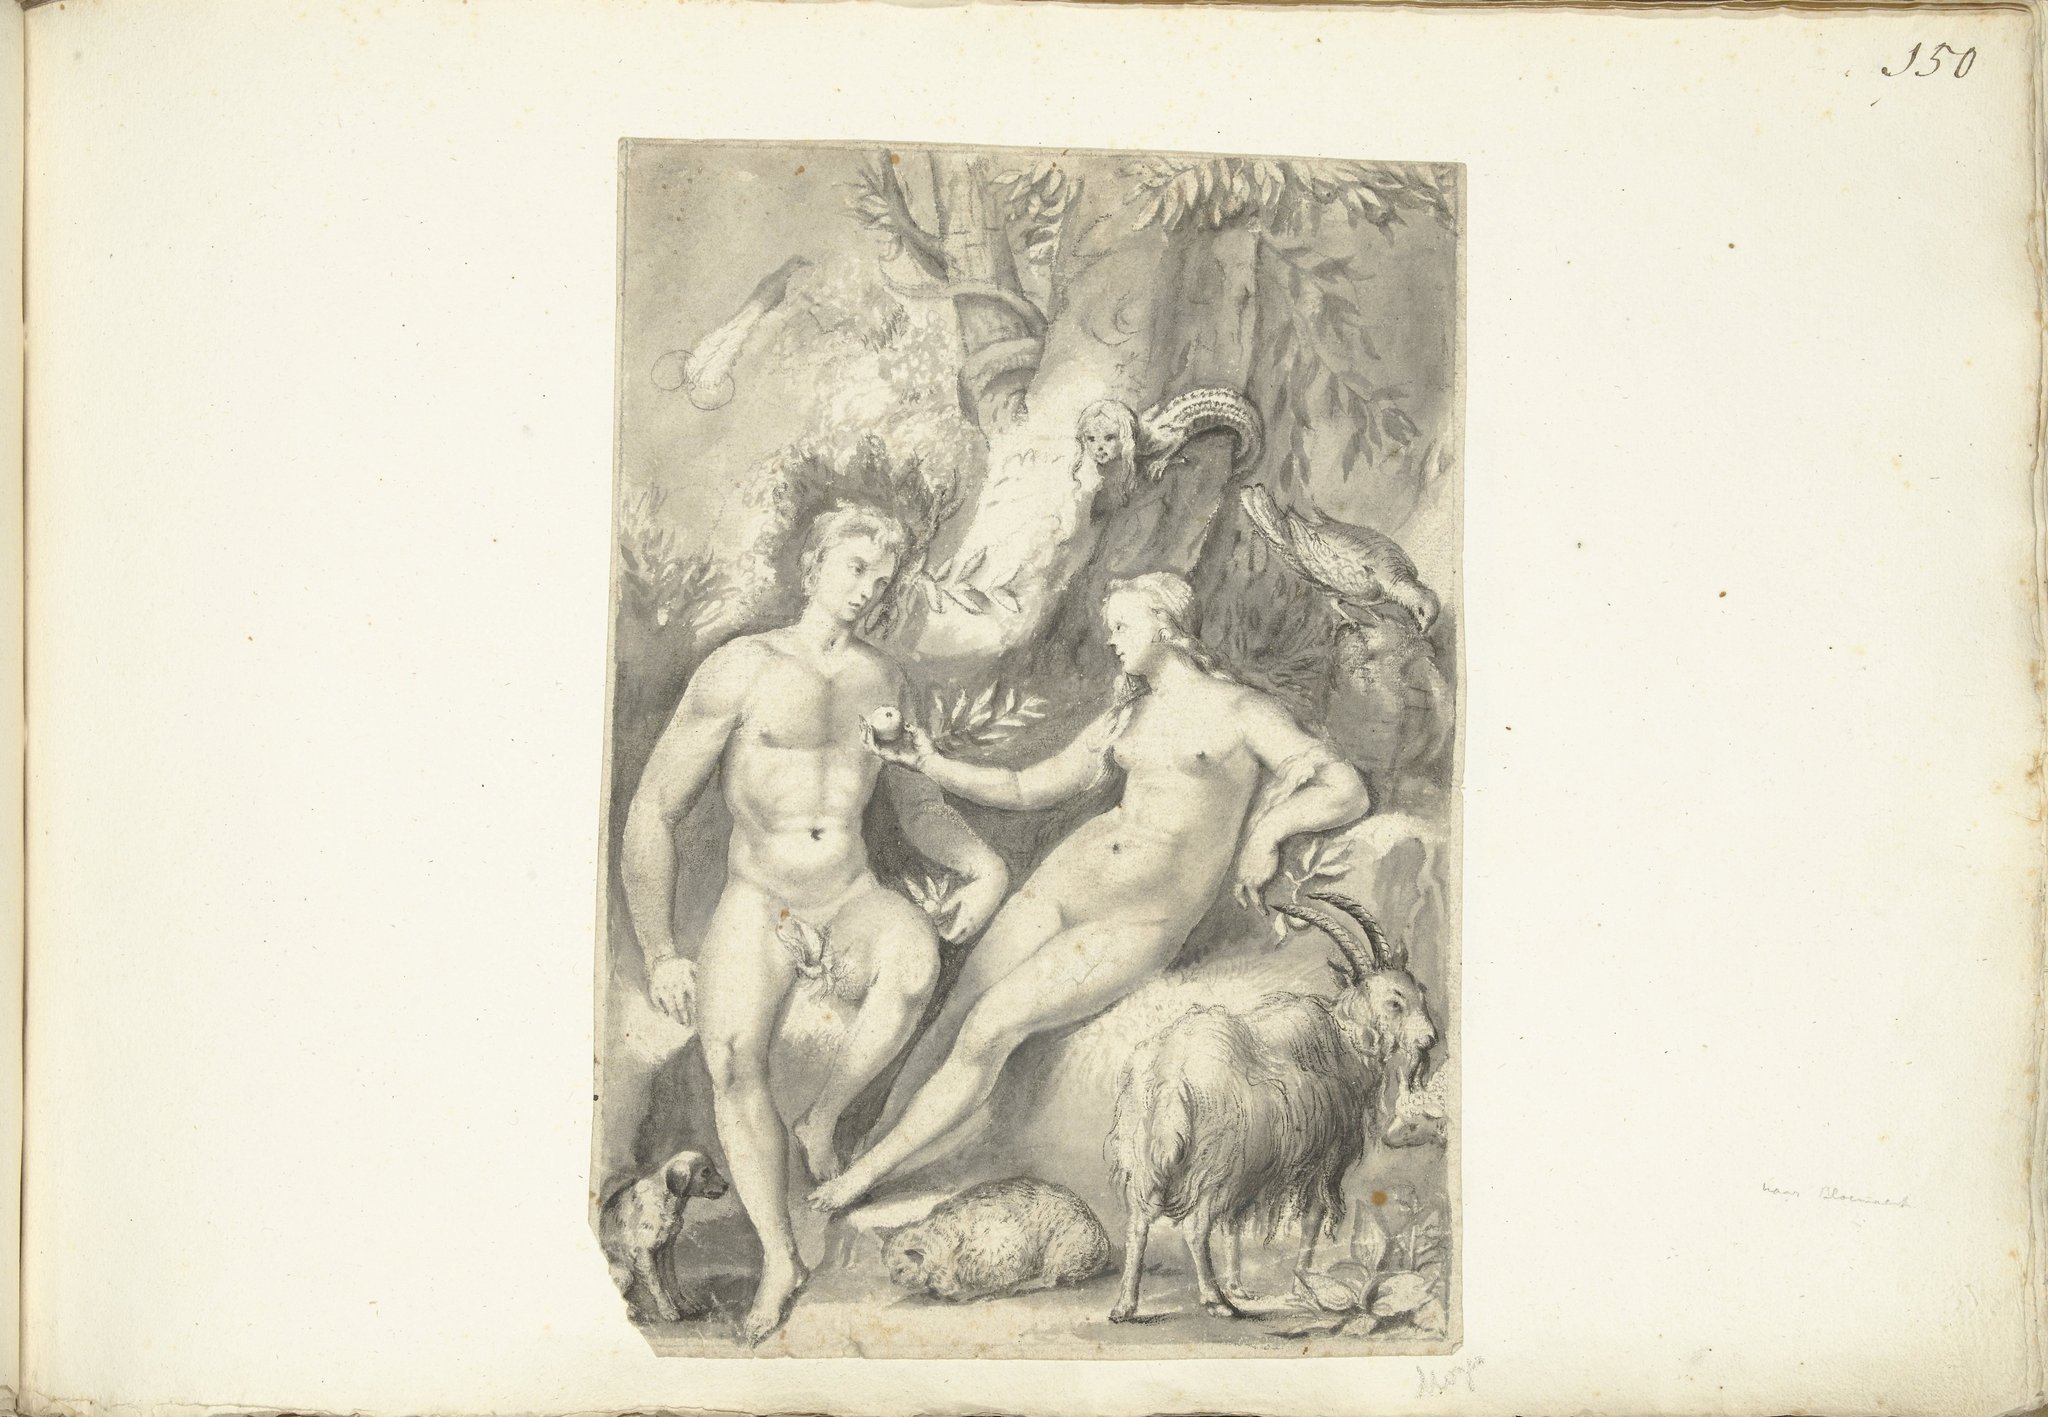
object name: drawing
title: Adam en Eva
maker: moses ter borch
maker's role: draughtsman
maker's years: 1645-1667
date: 1655-1660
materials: chalk, ink, paper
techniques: brush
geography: zwolle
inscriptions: annotation: ‘Mozes / naar Bloemaert’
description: Tekening opgeplakt in Familie-Plakboek. Kopie naar prent die in bezit was van de Ter Borchs, Jan Saenredams gravure Adam en Eva (RP-P-1887-A-12016) naar Hendrik Goltzius.